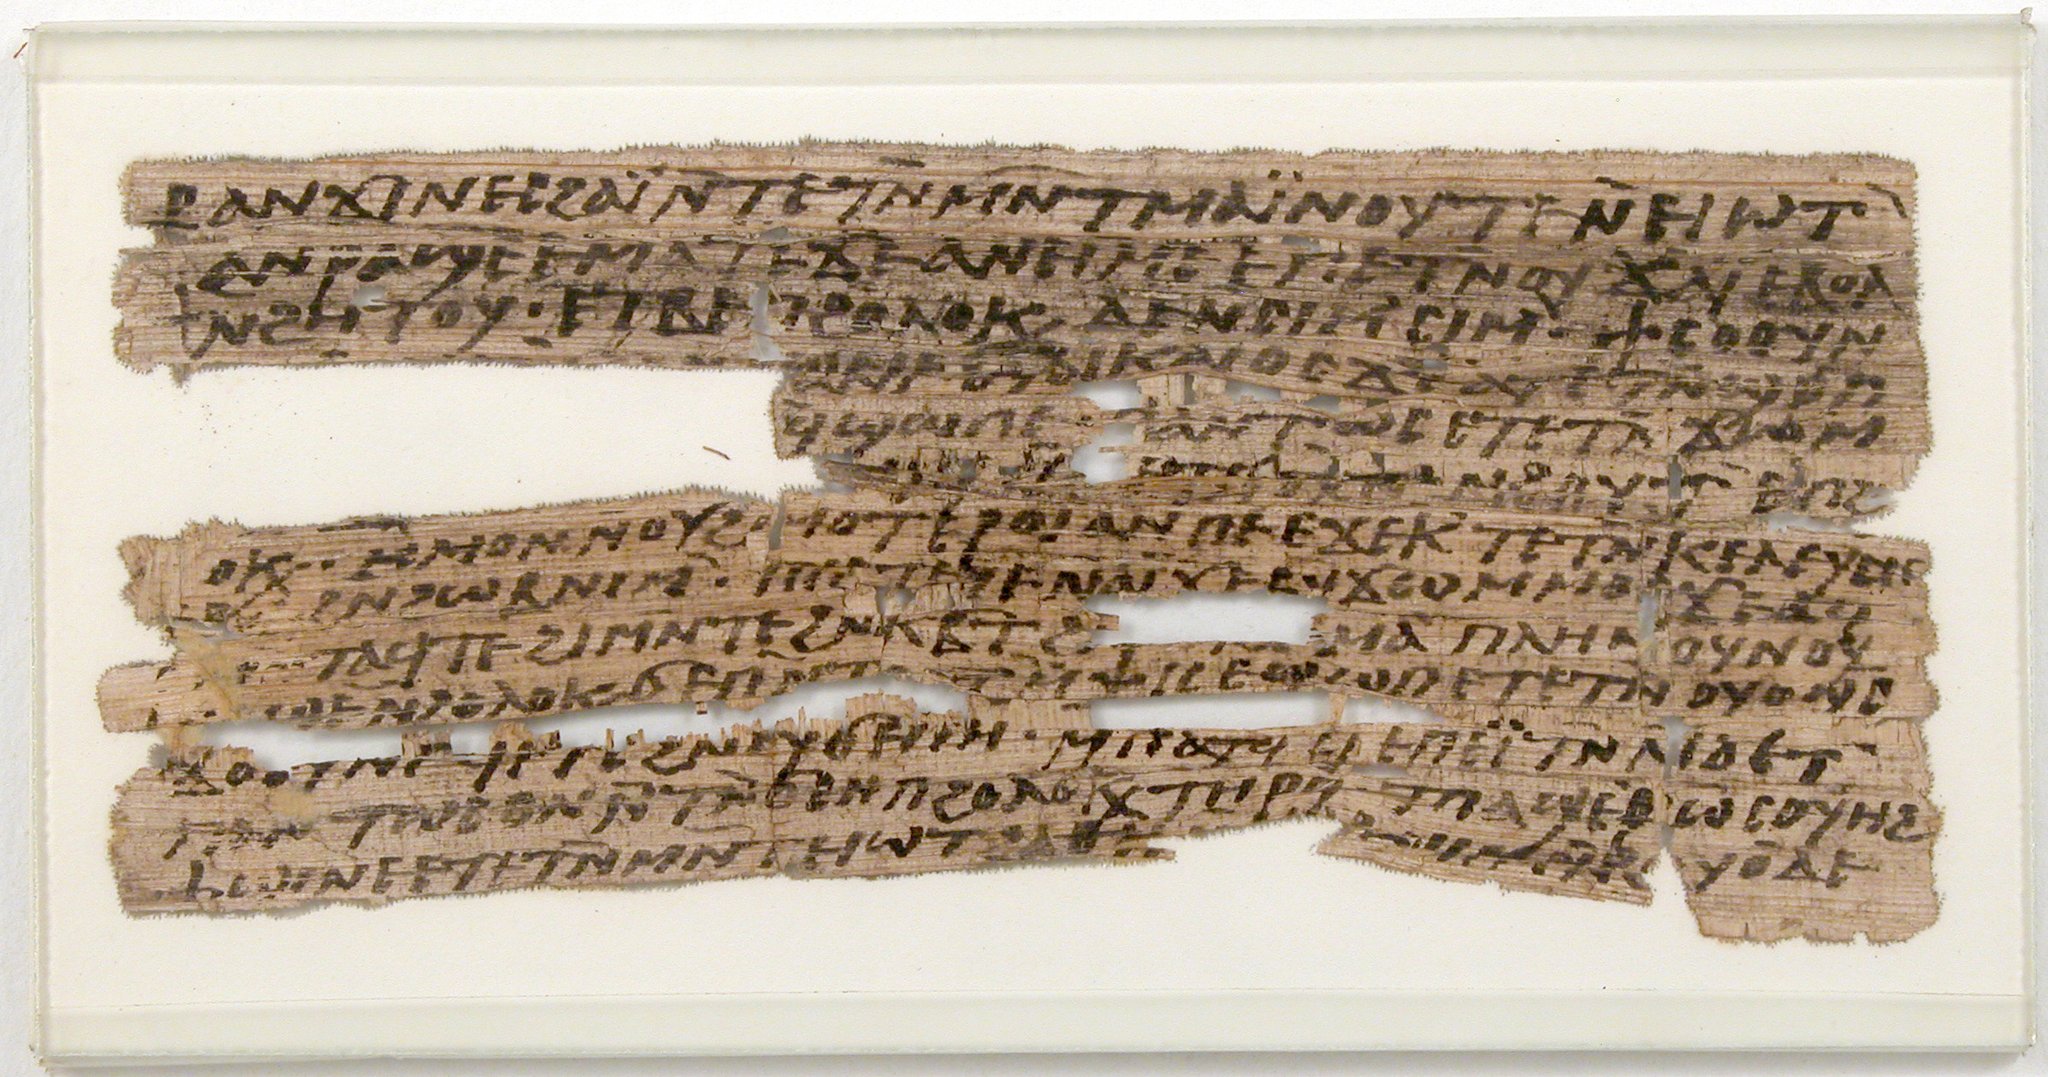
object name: fragment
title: Papyrus Fragment of a Letter from John to Elisaius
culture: coptic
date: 601-700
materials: ink, papyrus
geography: egypt